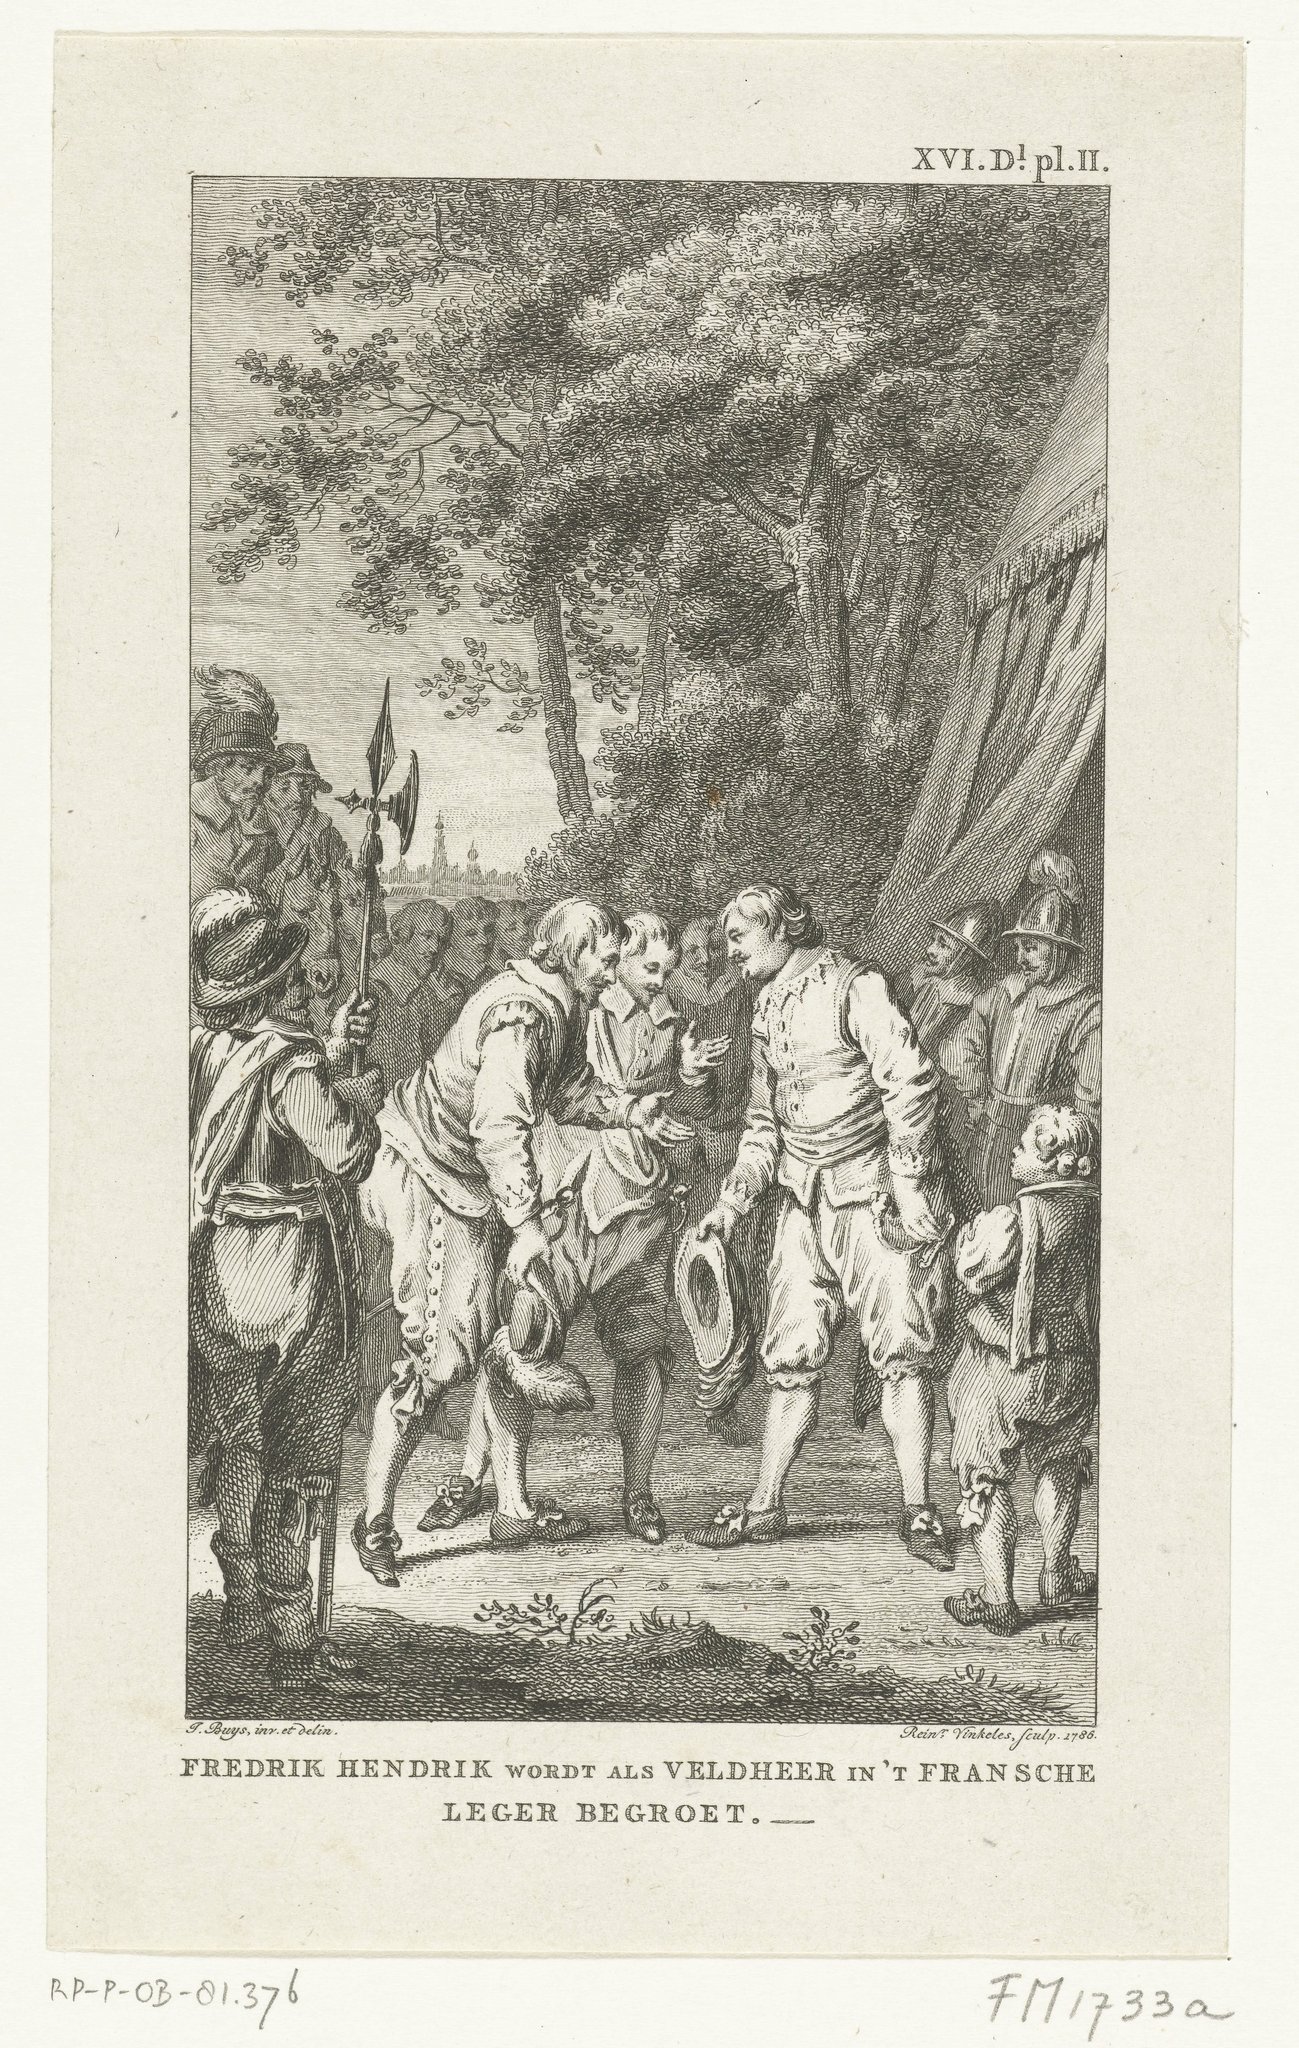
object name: history print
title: Frederik Hendrik wordt als veldheer in het Franse leger begroet, 1635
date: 1786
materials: paper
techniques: etching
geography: northern netherlands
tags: delft, frederick henry (prince of orange), siege, position war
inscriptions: date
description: Gebruikt als illustratie in: Jacobus Kok, Vaderlandsch Woordenboek, Johannes Allart, Amsterdam 1785-1799, 35 delen, dl. XVI, pl. II. Staat met de letter.